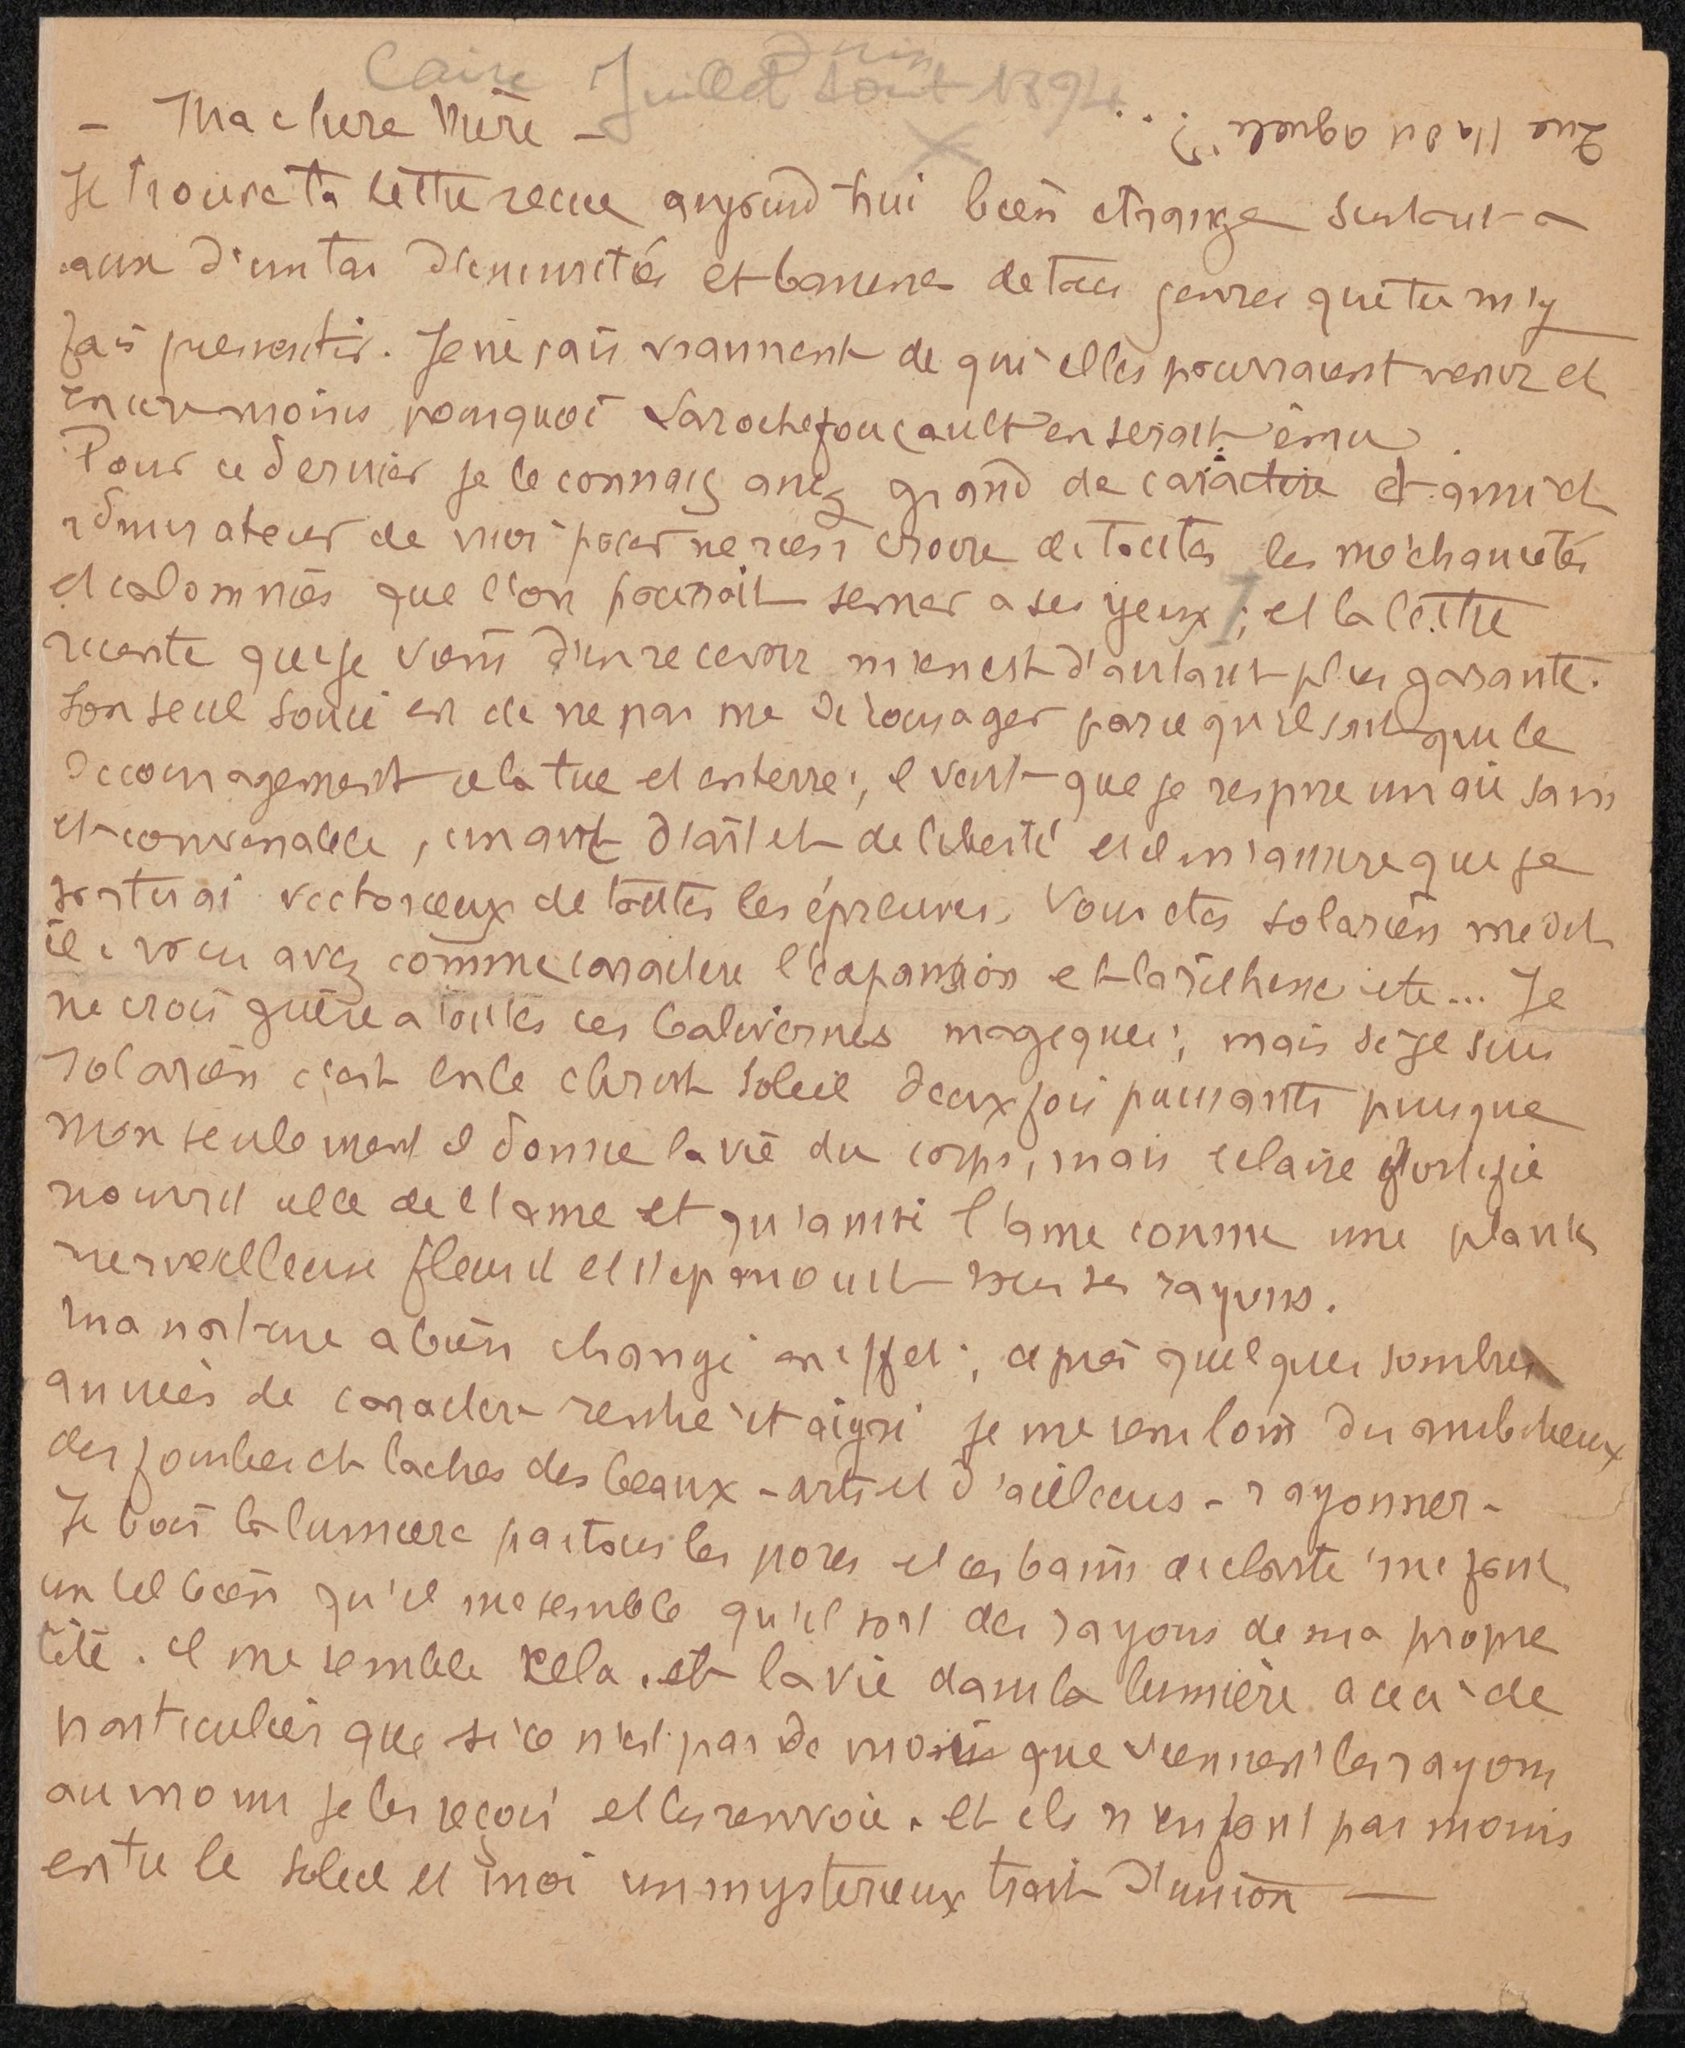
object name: letter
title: Brief aan Héloïse Bernard-Bodin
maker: émile bernard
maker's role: print maker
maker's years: 1868-1941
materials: ink, paper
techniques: pen, writing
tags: héloïse bernard-bodin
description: Brief gedateerd Juin Juillet Aout 1894 in latere hand.